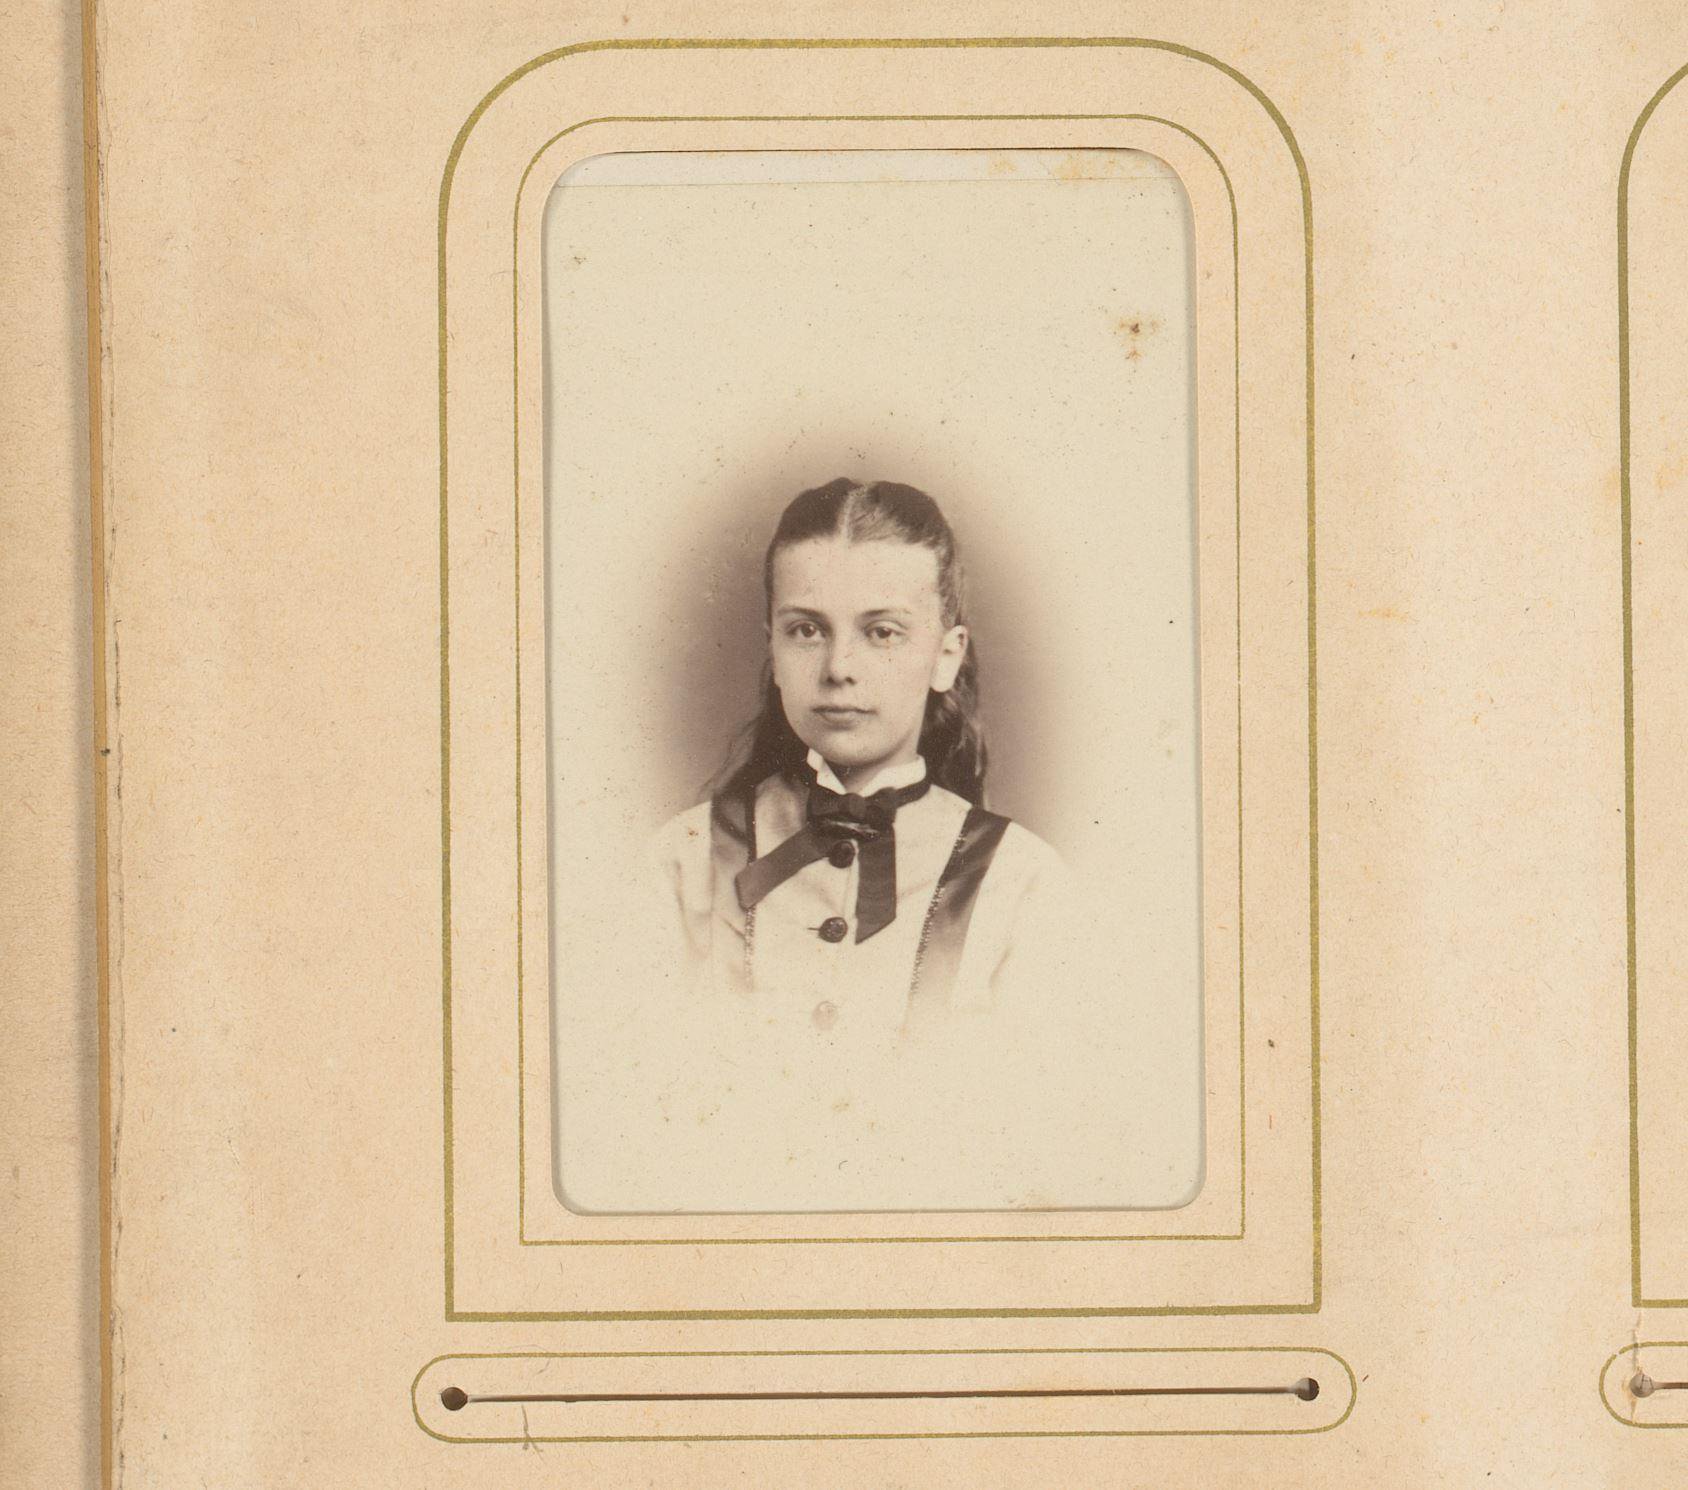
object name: album leaf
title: Portret van een meisje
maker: a. böeseken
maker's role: fotograaf, lithograaf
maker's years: 1834-1919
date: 1858-1890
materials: cardboard, photographic support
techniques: albumen print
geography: rotterdam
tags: historical persons - bb - woman, girl (child between toddler and youth)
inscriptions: inscription: ‘A. Böeseken/ Photographisch Atelier/ ROTTERDAM/ Hoogstraat over de Vlasmarkt’